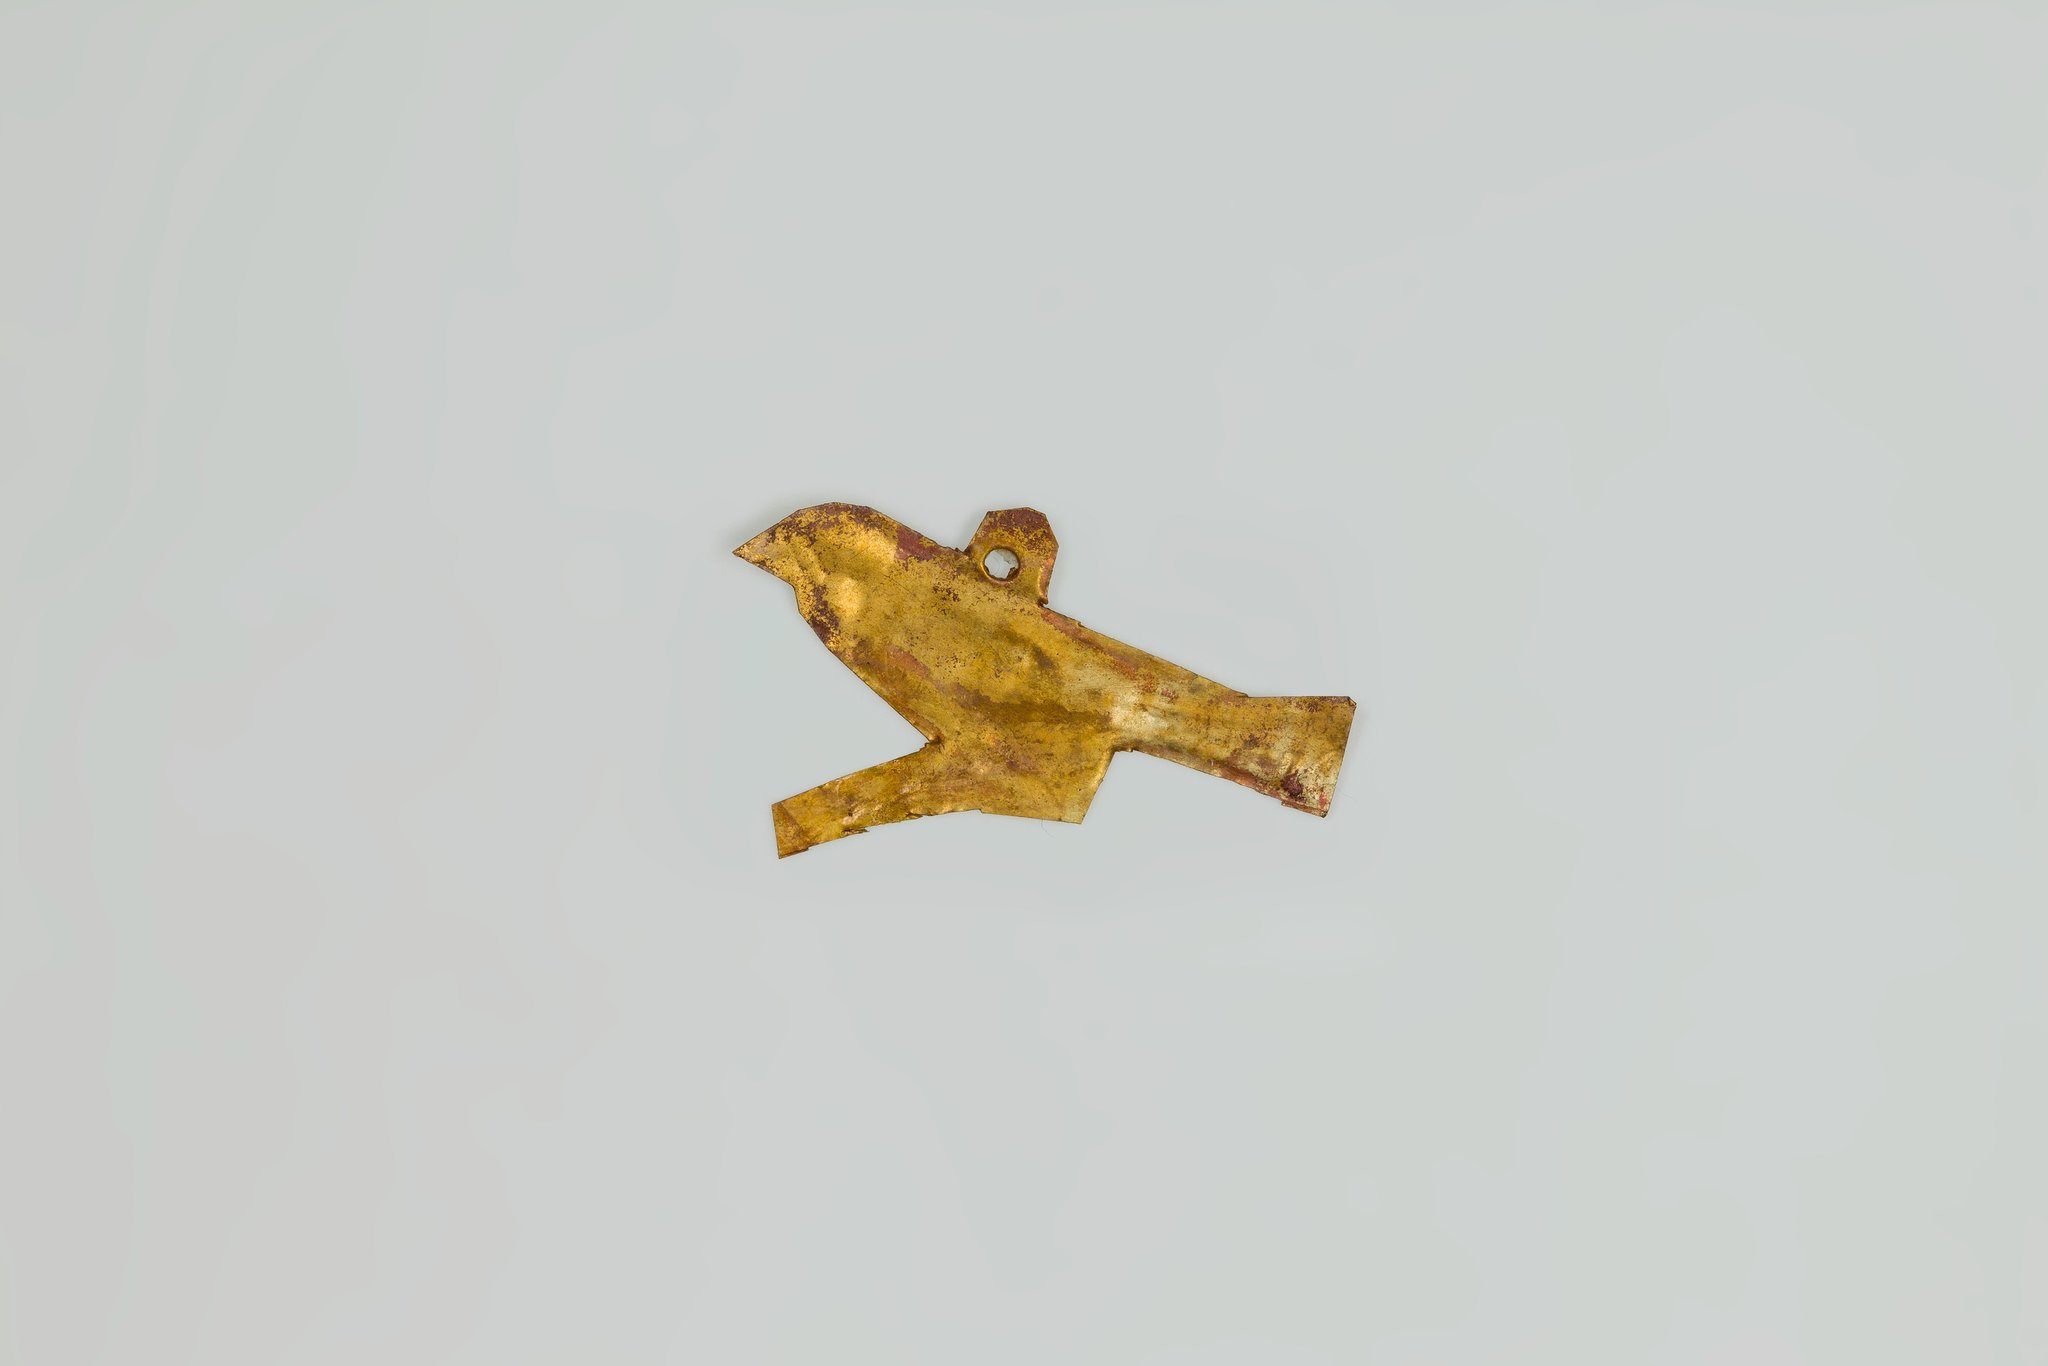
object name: amulet, swallow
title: Swallow amulet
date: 664-380 BCE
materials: gold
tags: birds